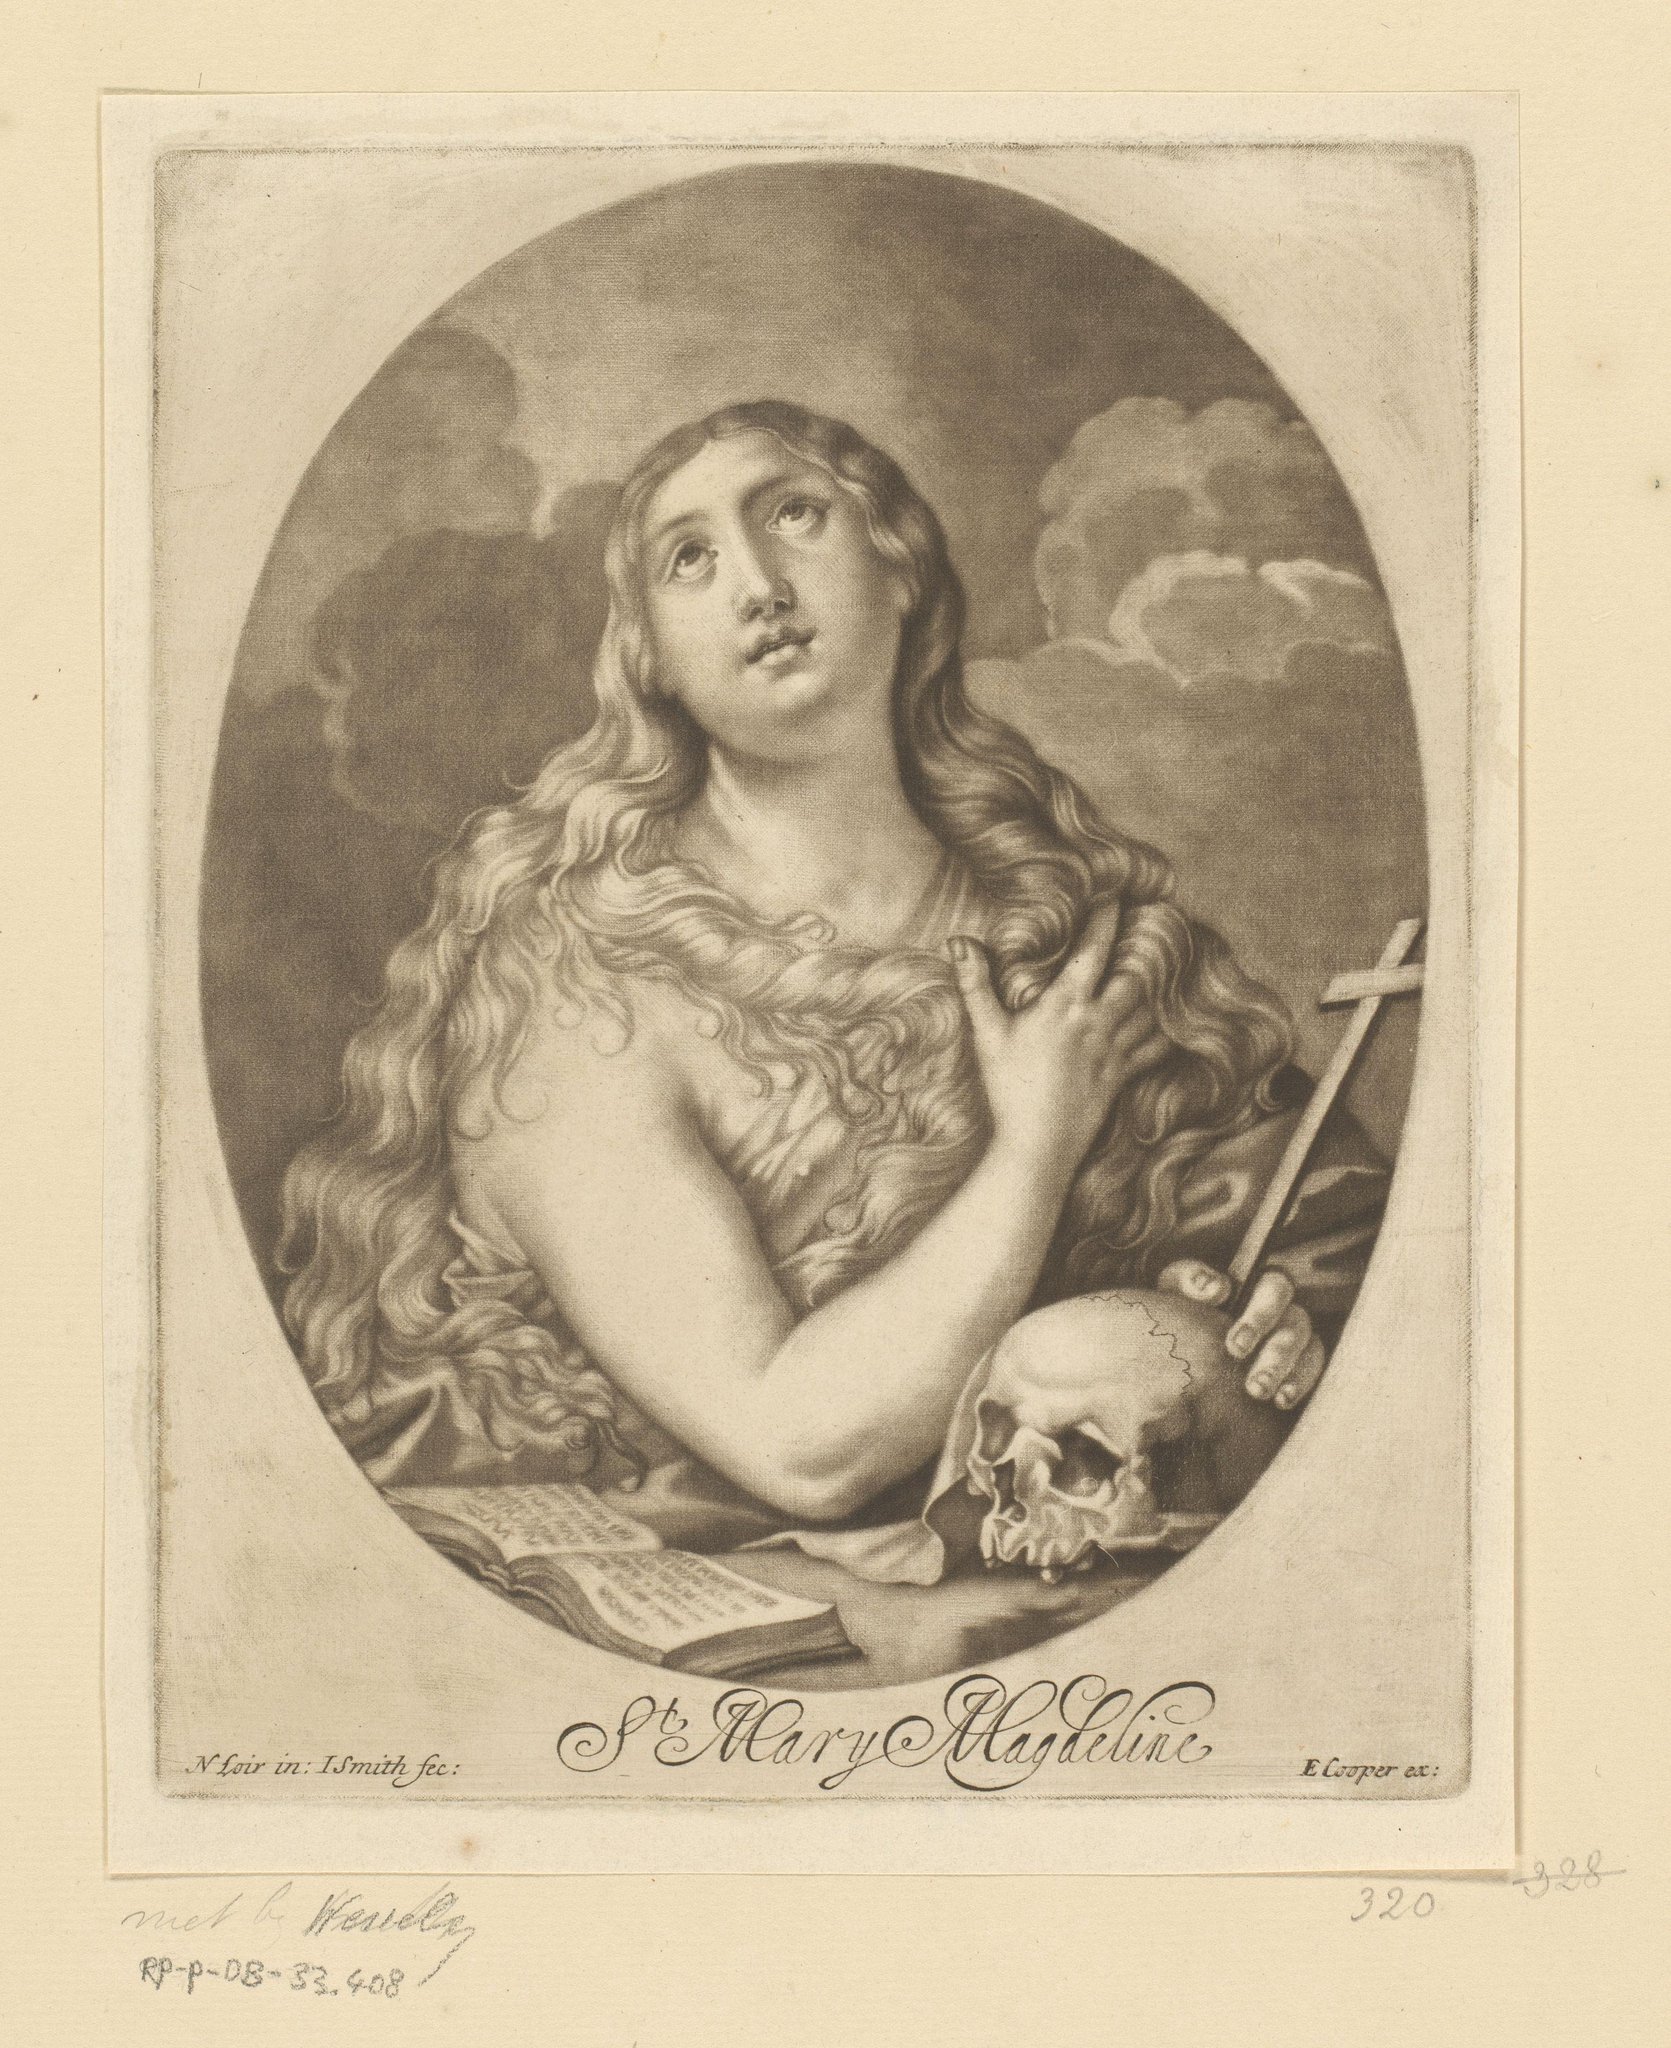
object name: print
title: St Mary Magdeline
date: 1662-1725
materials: paper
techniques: mezzotint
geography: london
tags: the penitent harlot mary magdalene; possible attributes: book (or scroll), crown, crown of thorns, crucifix, jar of ointment, mirror, musical instrument, palm-branch, rosary, scourge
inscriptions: collector's mark: Lugt 240